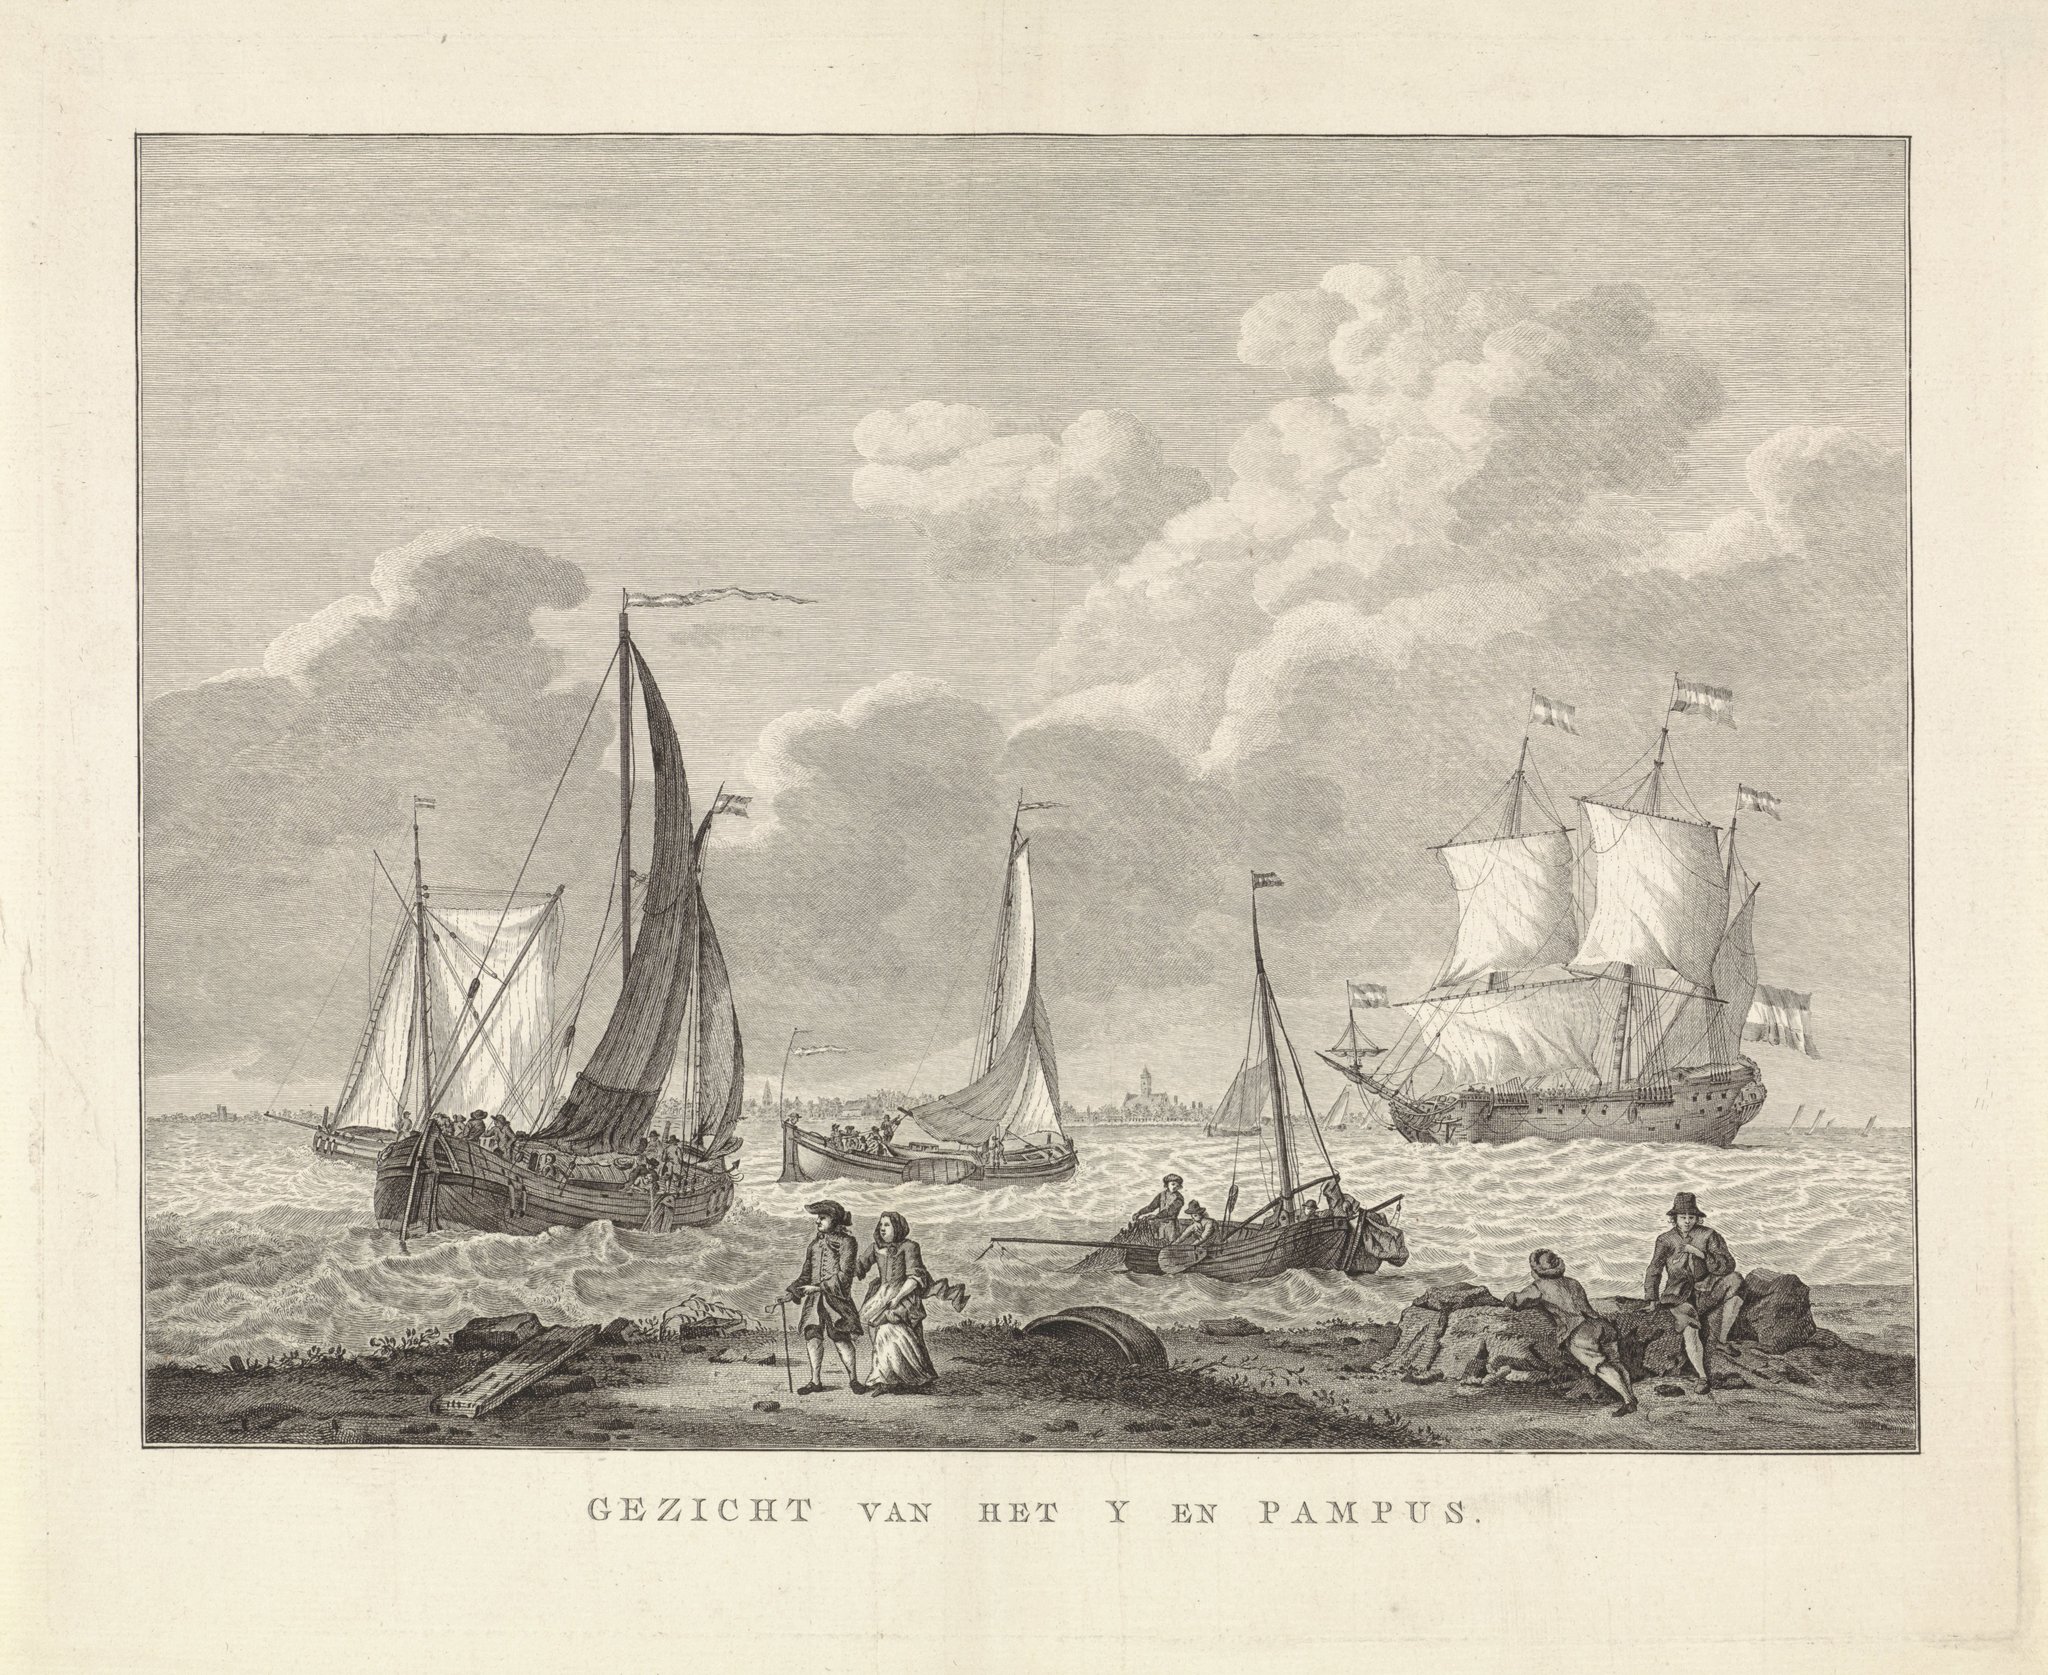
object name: print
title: Gezicht van het IJ en Pampus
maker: mathias de sallieth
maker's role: print maker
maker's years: 1749-1791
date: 1785-1791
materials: paper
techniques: etching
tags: fortress, sailing-ship, sailing-boat, zuiderzee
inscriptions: collector's mark: Lugt 2228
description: Gezicht over het IJ naar Pampus. Op het water varen verschillende zeilschepen, op de oever bevinden zich vier figuren.